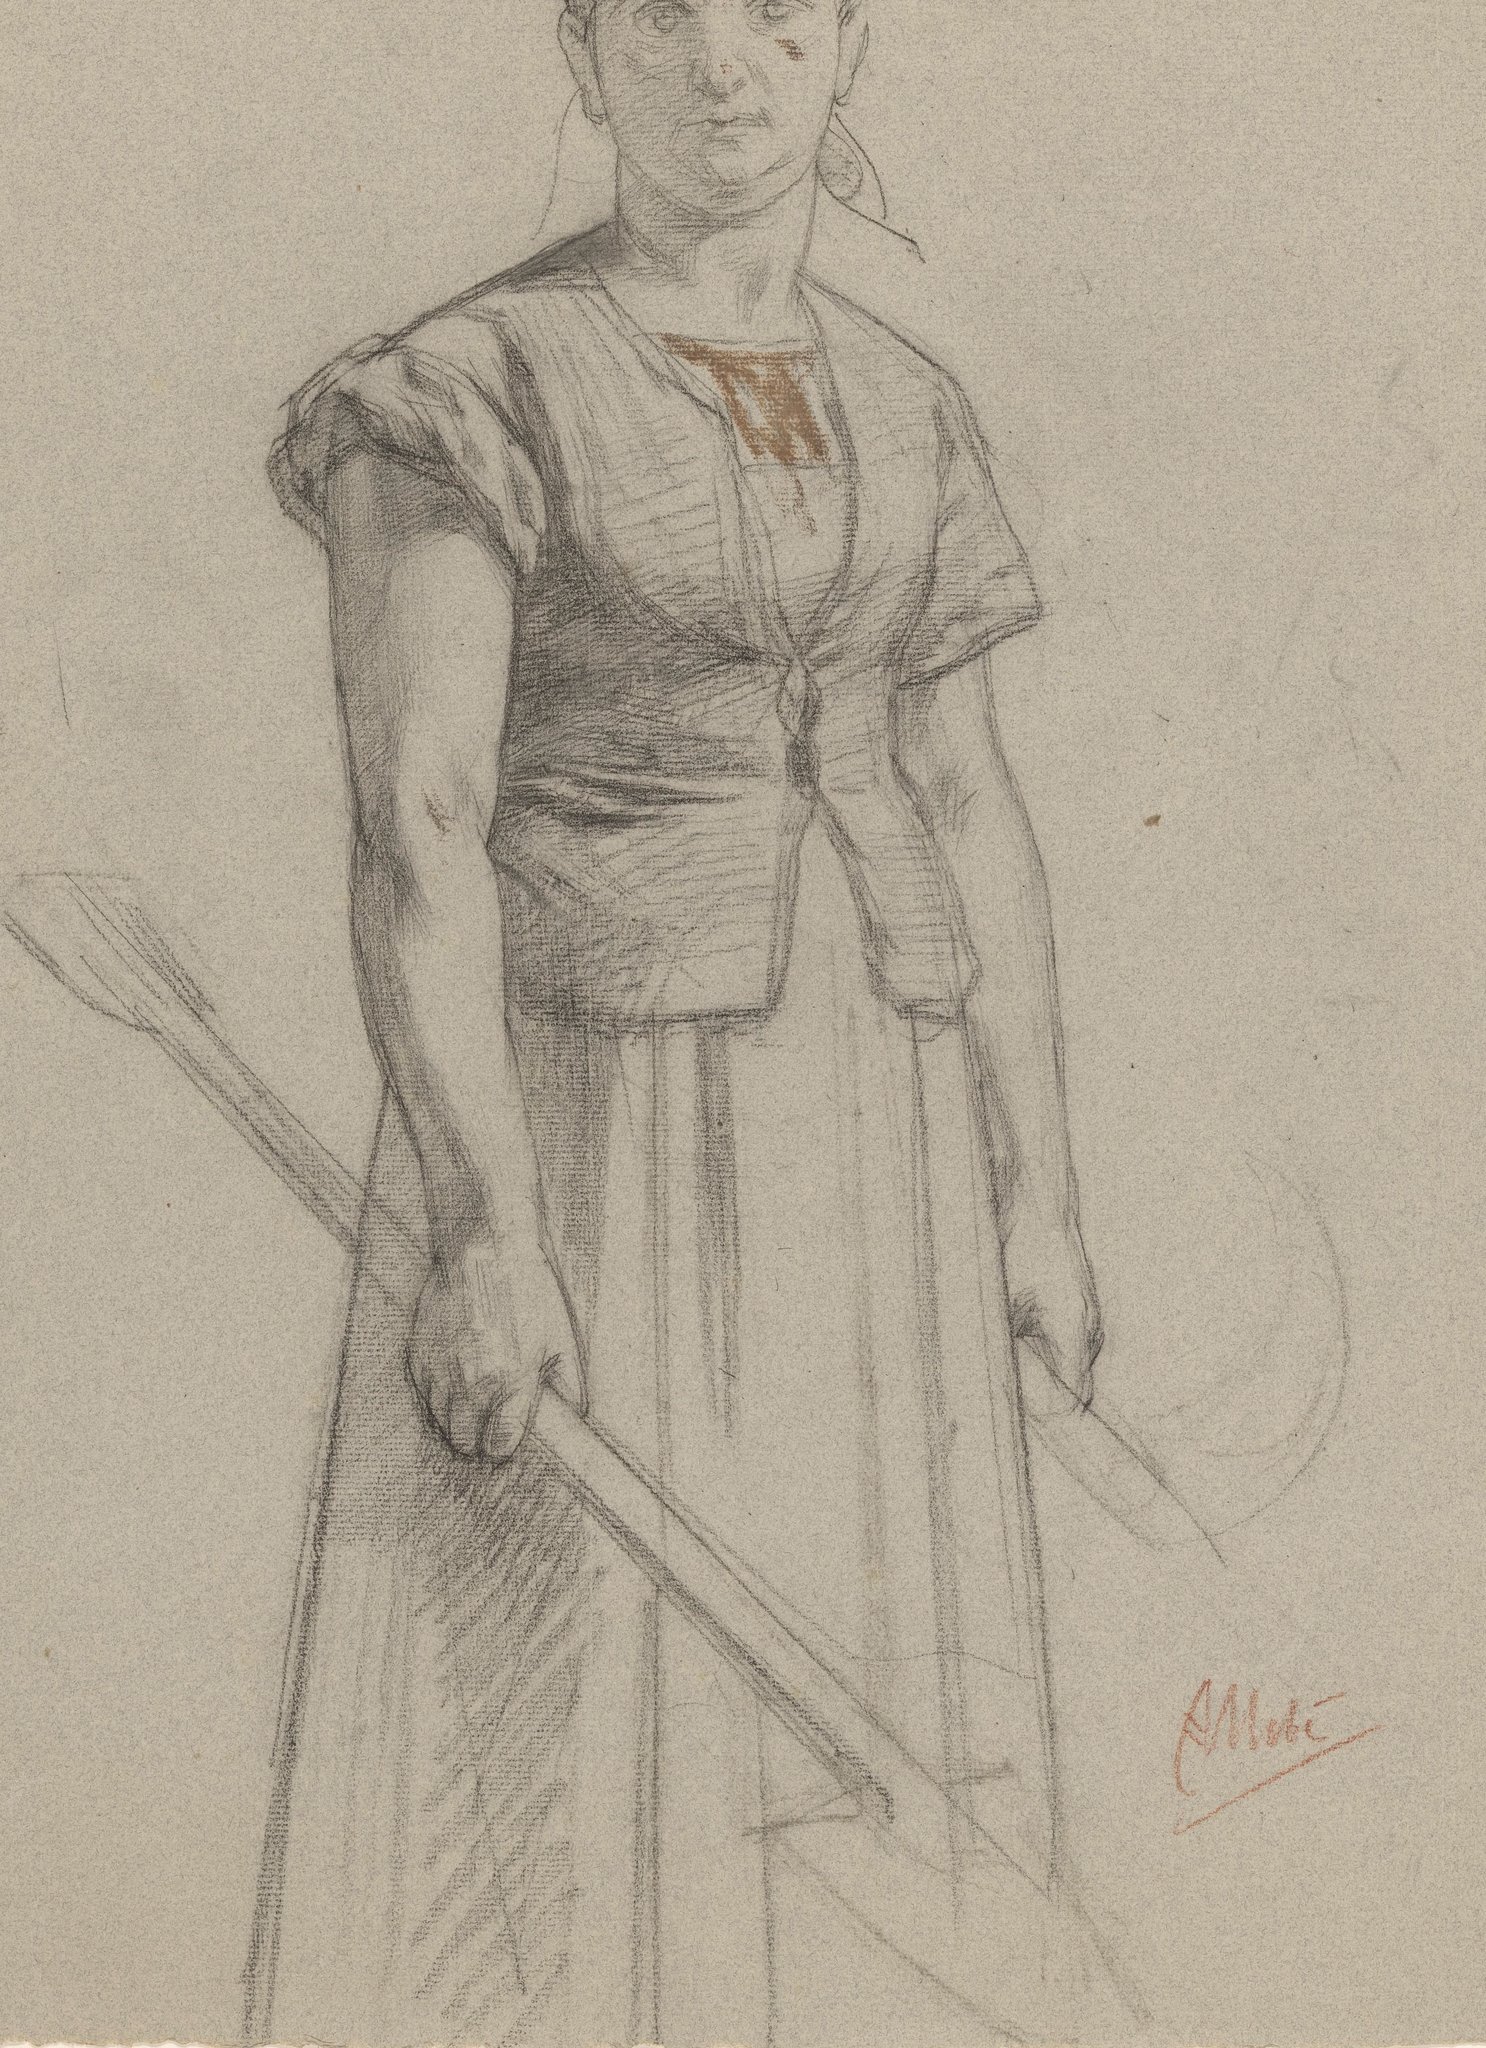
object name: drawing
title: Labor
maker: august allebé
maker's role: draughtsman, print maker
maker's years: 1838-1927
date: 1848-1927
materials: chalk, paper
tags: farmers - aa - female farmer, farmer's wife